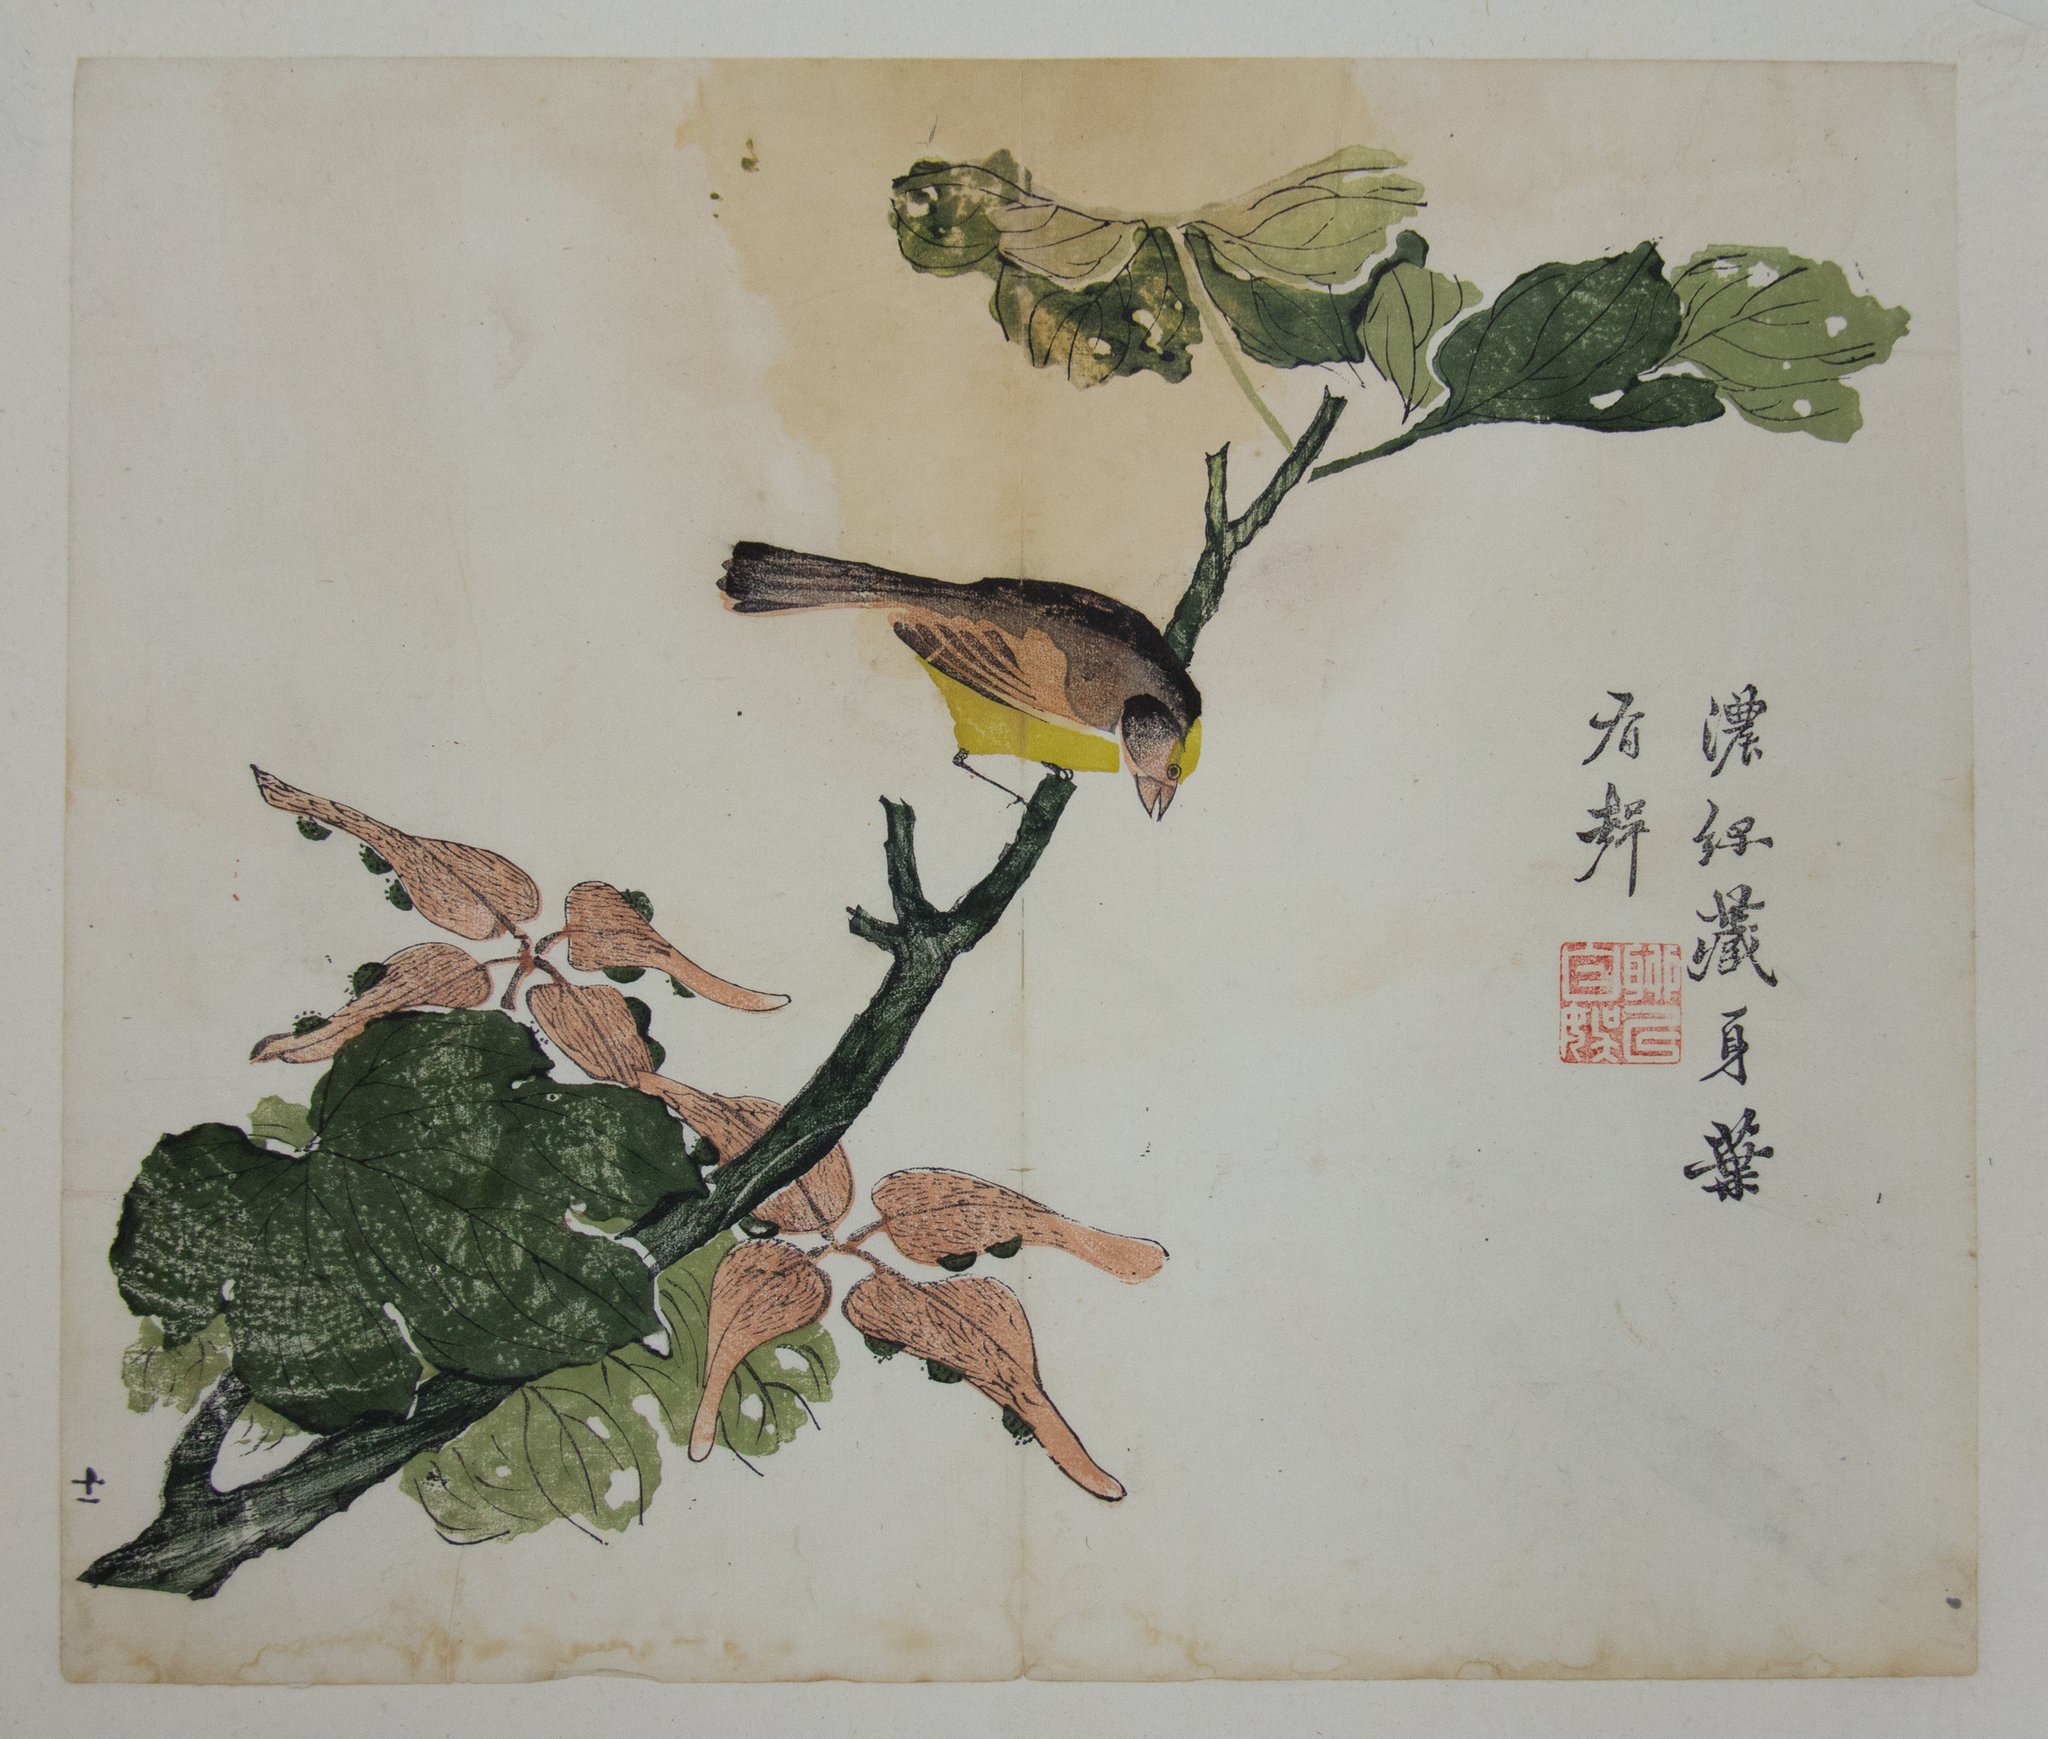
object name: print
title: Seeds and Aleurities Cordata (?): Page from The Mustard Seed Garden Manual of Painting (Jieziyuan huazhuan)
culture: chinese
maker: dao cheng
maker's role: artist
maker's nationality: chinese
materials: ink, paper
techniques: polychrome, woodblock print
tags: birds